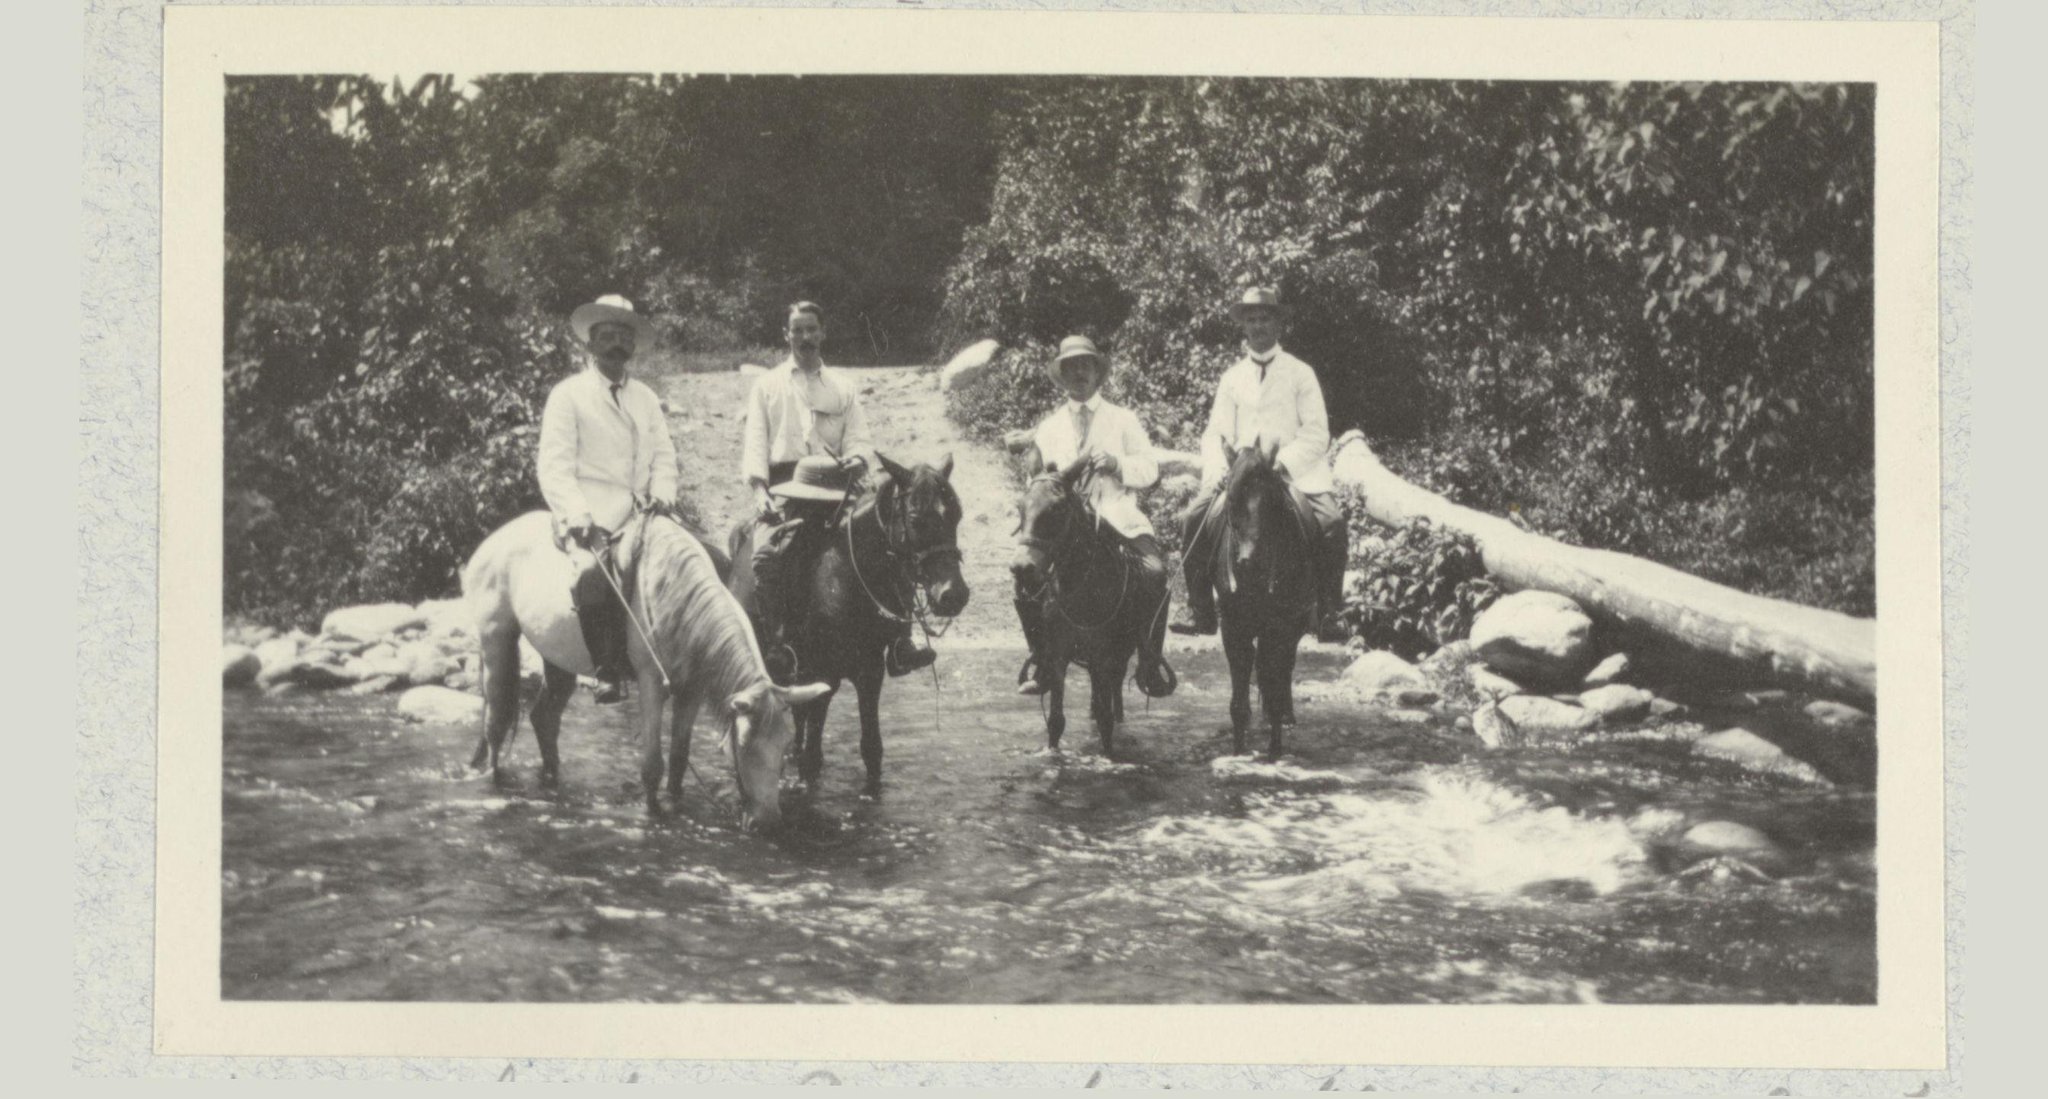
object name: photograph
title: Paardenrit in Honduras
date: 1908-1912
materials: photographic support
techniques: photography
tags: riding a horse, ass, or mule; rider, horseman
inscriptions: inscription: ‘Rivier bij San Pedro Sula. Honduras. Aug. '12.’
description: Een groep van vier mannen laat hun paarden drinken in een rivier bij San Pedro Sula in Honduras, augustus 1912. Onderdeel van het fotoalbum van de familie Boom-Gonggrijp in Suriname en Curaçao.